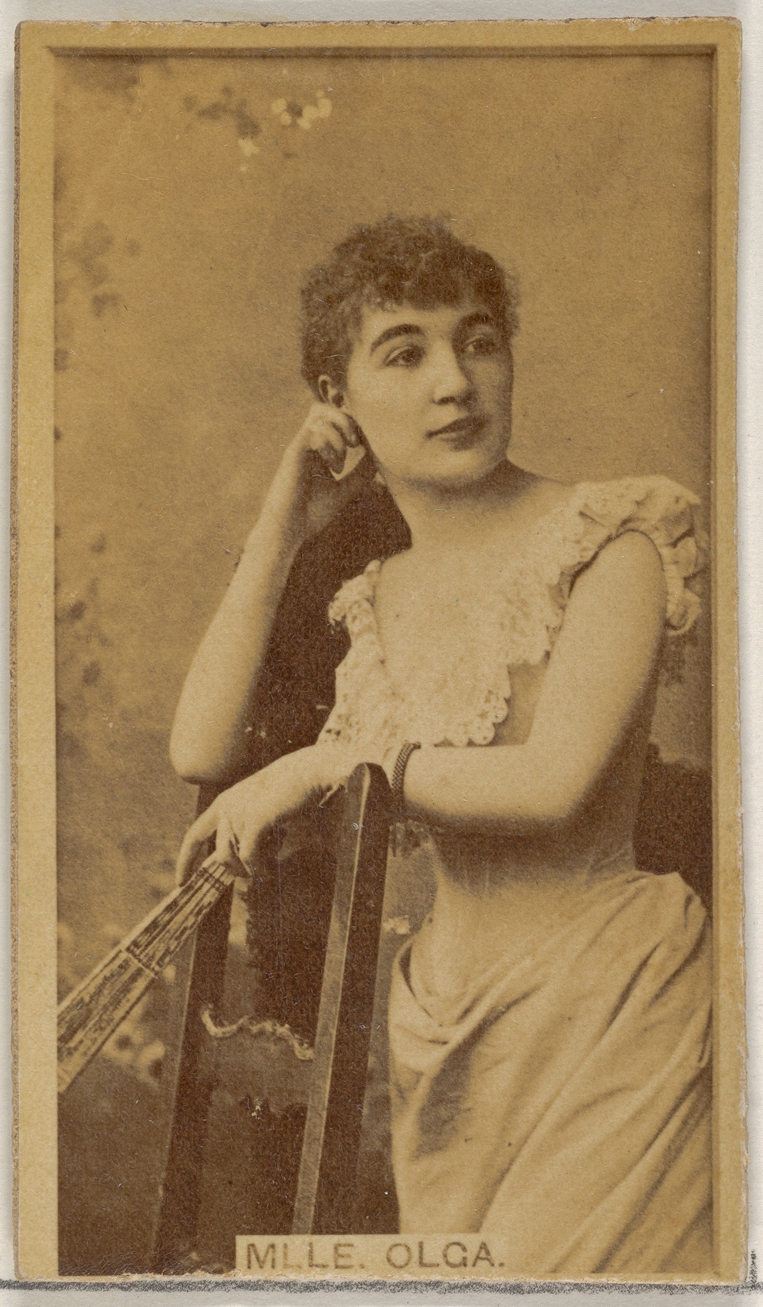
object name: photograph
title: Mlle. Olga, from the Actors and Actresses series (N45, Type 8) for Virginia Brights Cigarettes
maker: allen & ginter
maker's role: publisher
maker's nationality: american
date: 1888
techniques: albumen silver print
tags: portraits,women,actresses